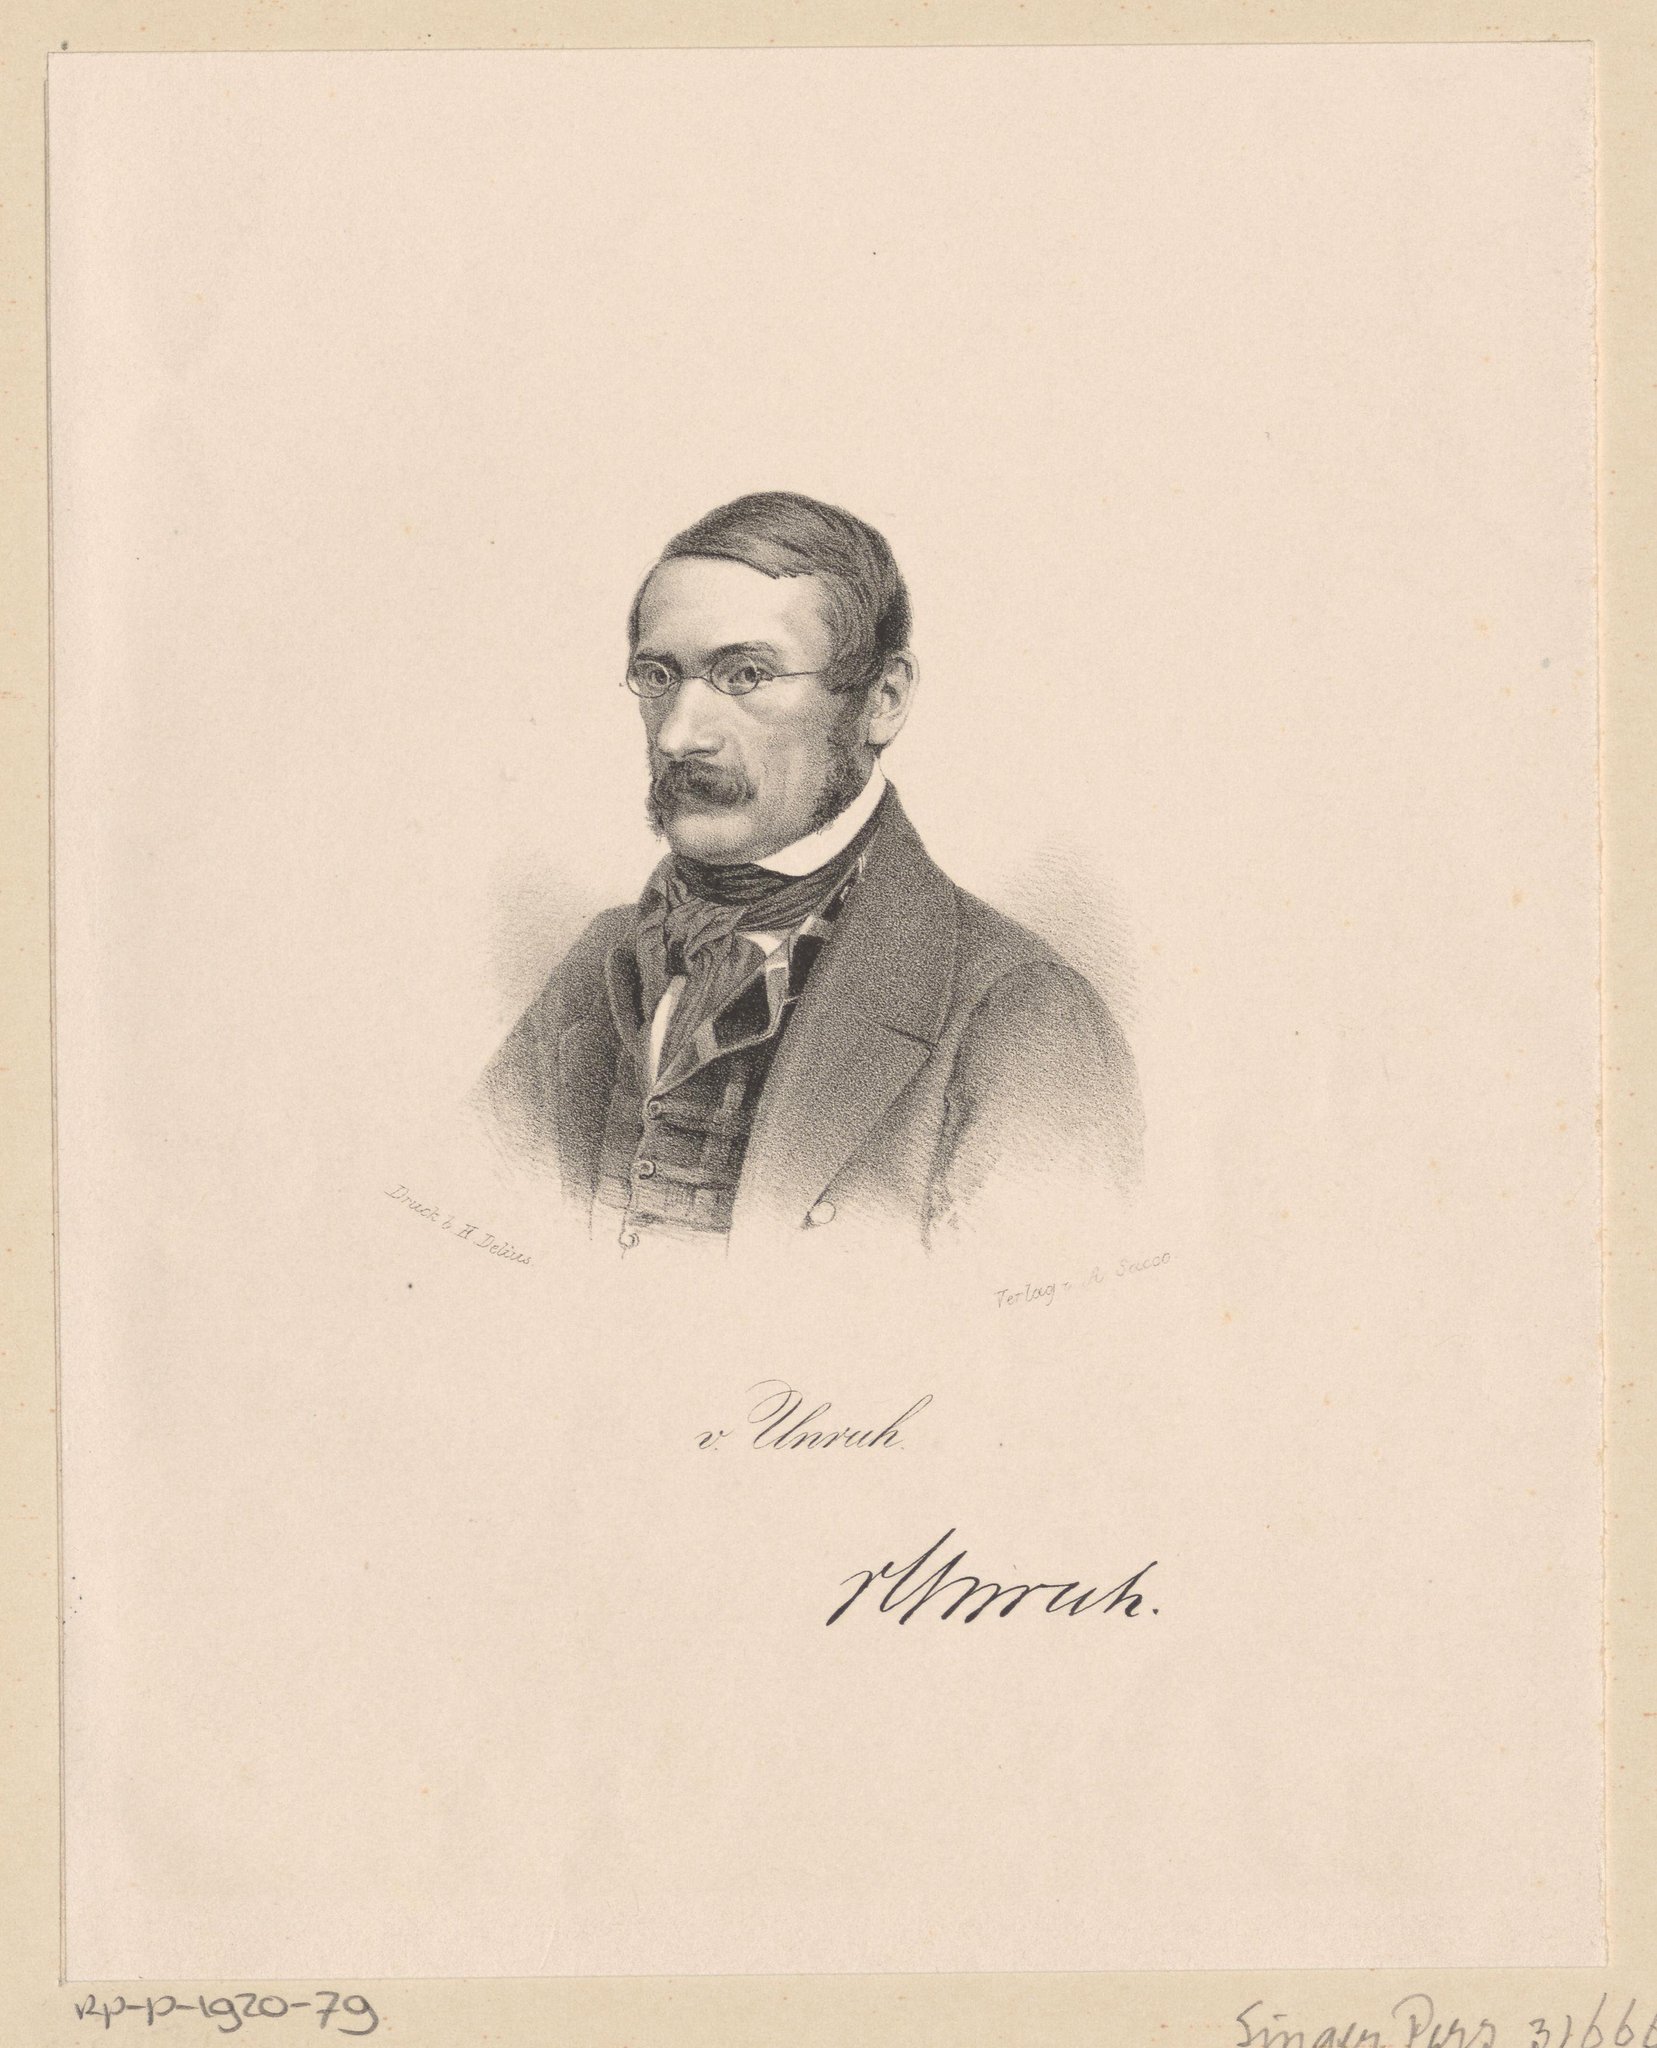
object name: print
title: Portret van Hans Victor von Unruh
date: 1842-1863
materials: paper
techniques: lithograph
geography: berlin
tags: historical persons, politician, e.g. party leader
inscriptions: collector's mark: Lugt 2228